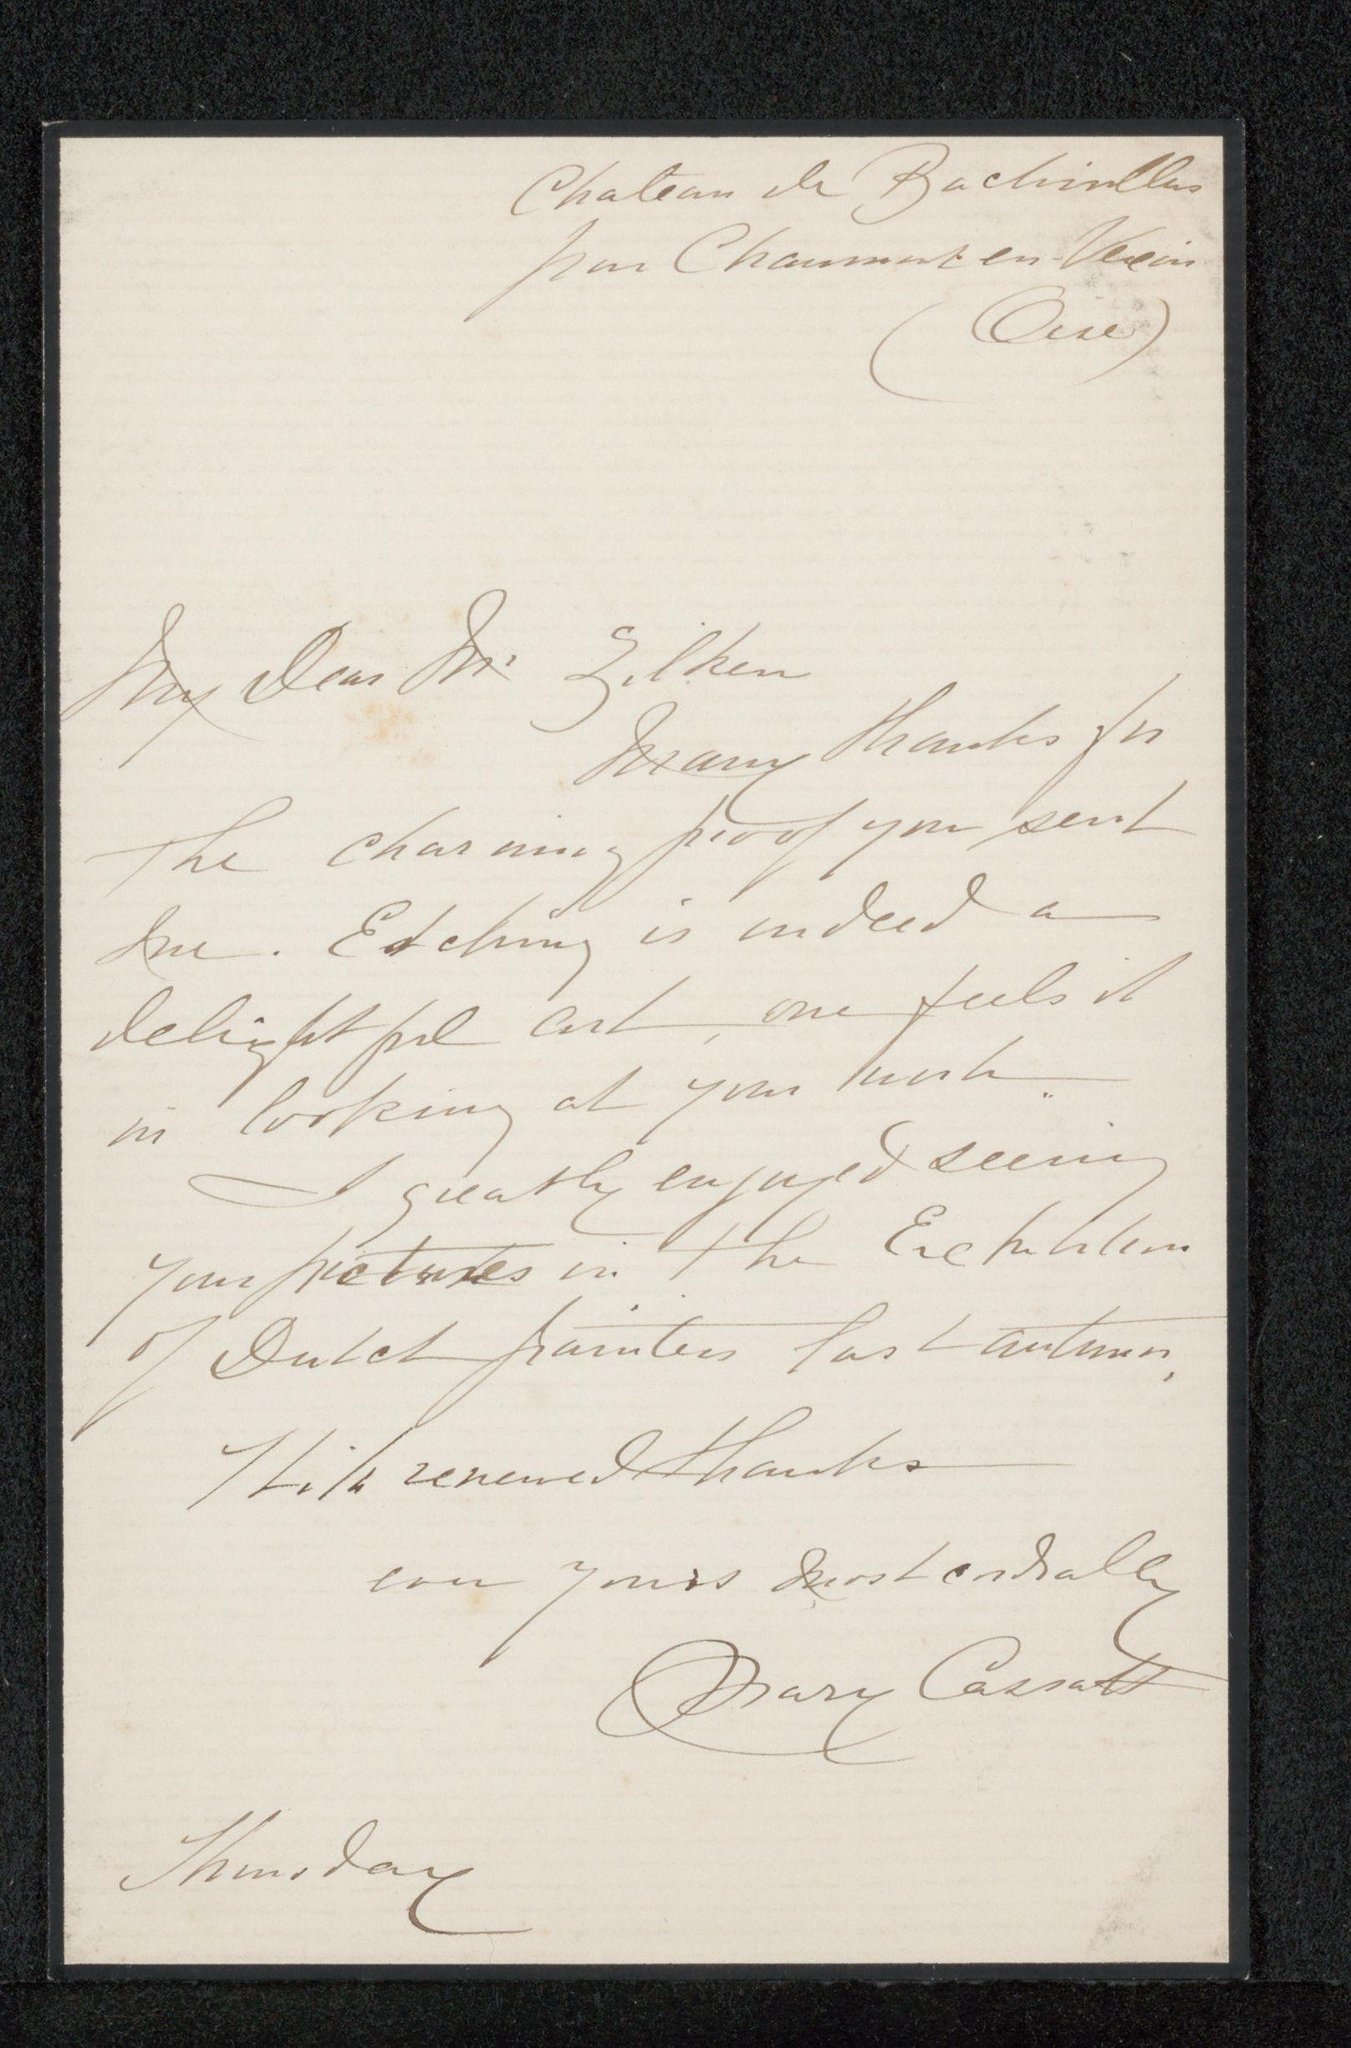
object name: letter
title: Brief aan Philip Zilcken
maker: mary cassatt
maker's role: print maker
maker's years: 1844-1926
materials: ink, paper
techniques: pen, writing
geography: château de bachivillers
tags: the hague, painter, philip zilcken, etching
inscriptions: collector's mark: ‘RPK’